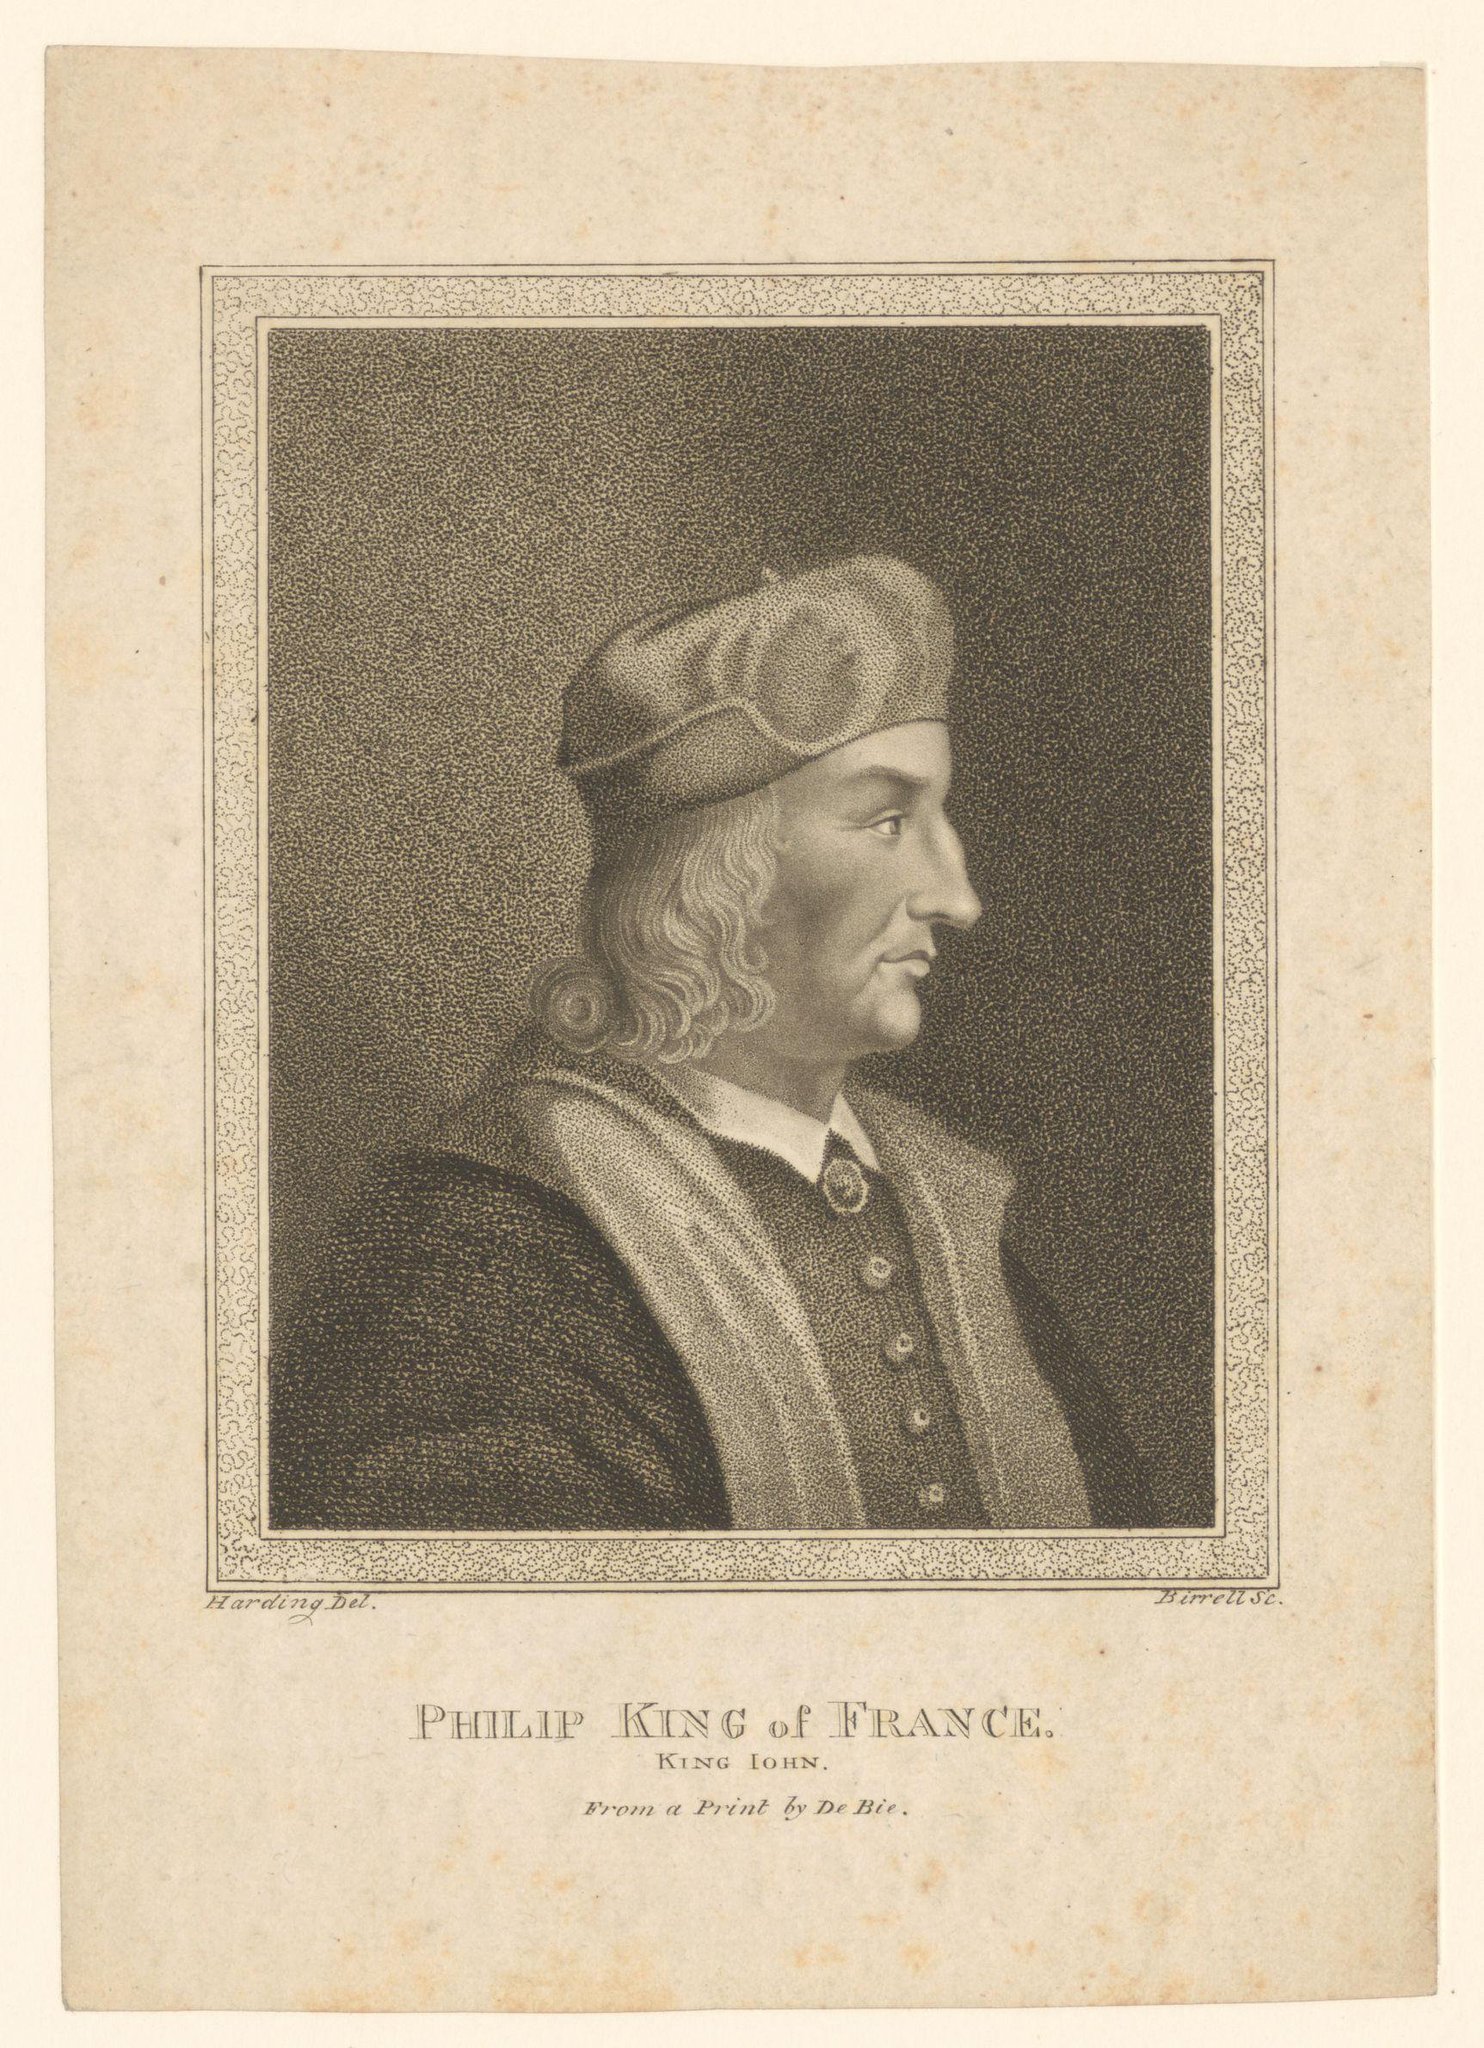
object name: print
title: Illustraties bij Shakespeares toneelstukken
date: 1793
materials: paper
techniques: engraving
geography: england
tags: paris, historical persons, king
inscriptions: collector's mark: Lugt 2228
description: Prent uit: Shak[e]speare Illustrated (...). Londen: Sylvester en Edward Harding, 1793.